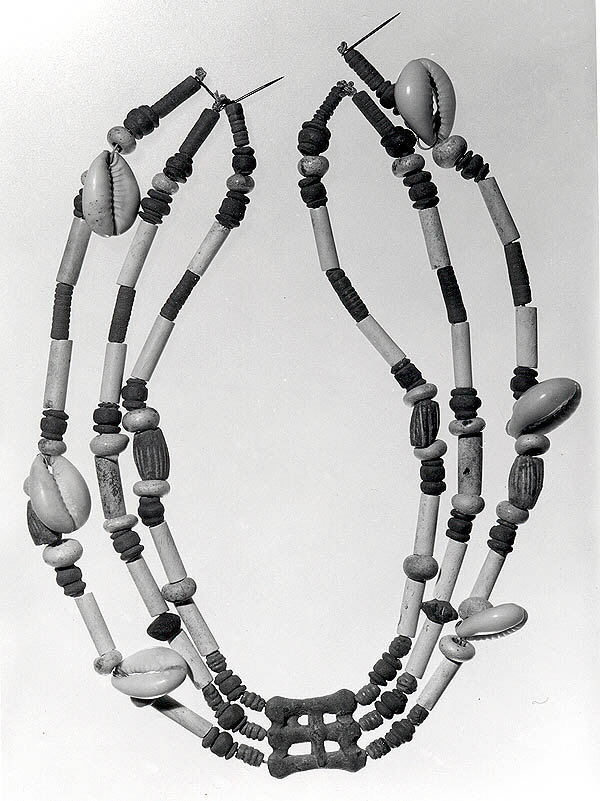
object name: bead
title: Beads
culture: iranian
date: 900-801 BCE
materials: faience, glass, shell, stone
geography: iran